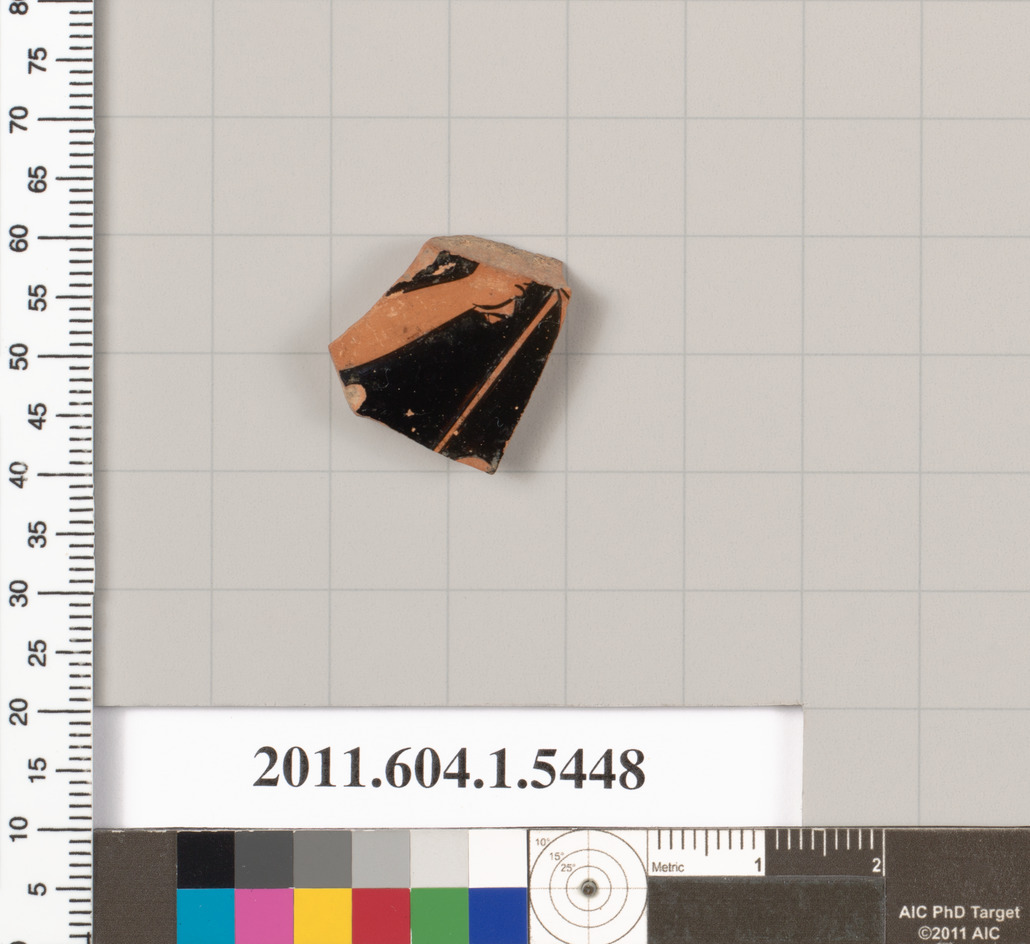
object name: kylix fragment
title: Terracotta fragment of a kylix (drinking cup)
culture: greek, attic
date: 500-480 BCE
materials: terracotta